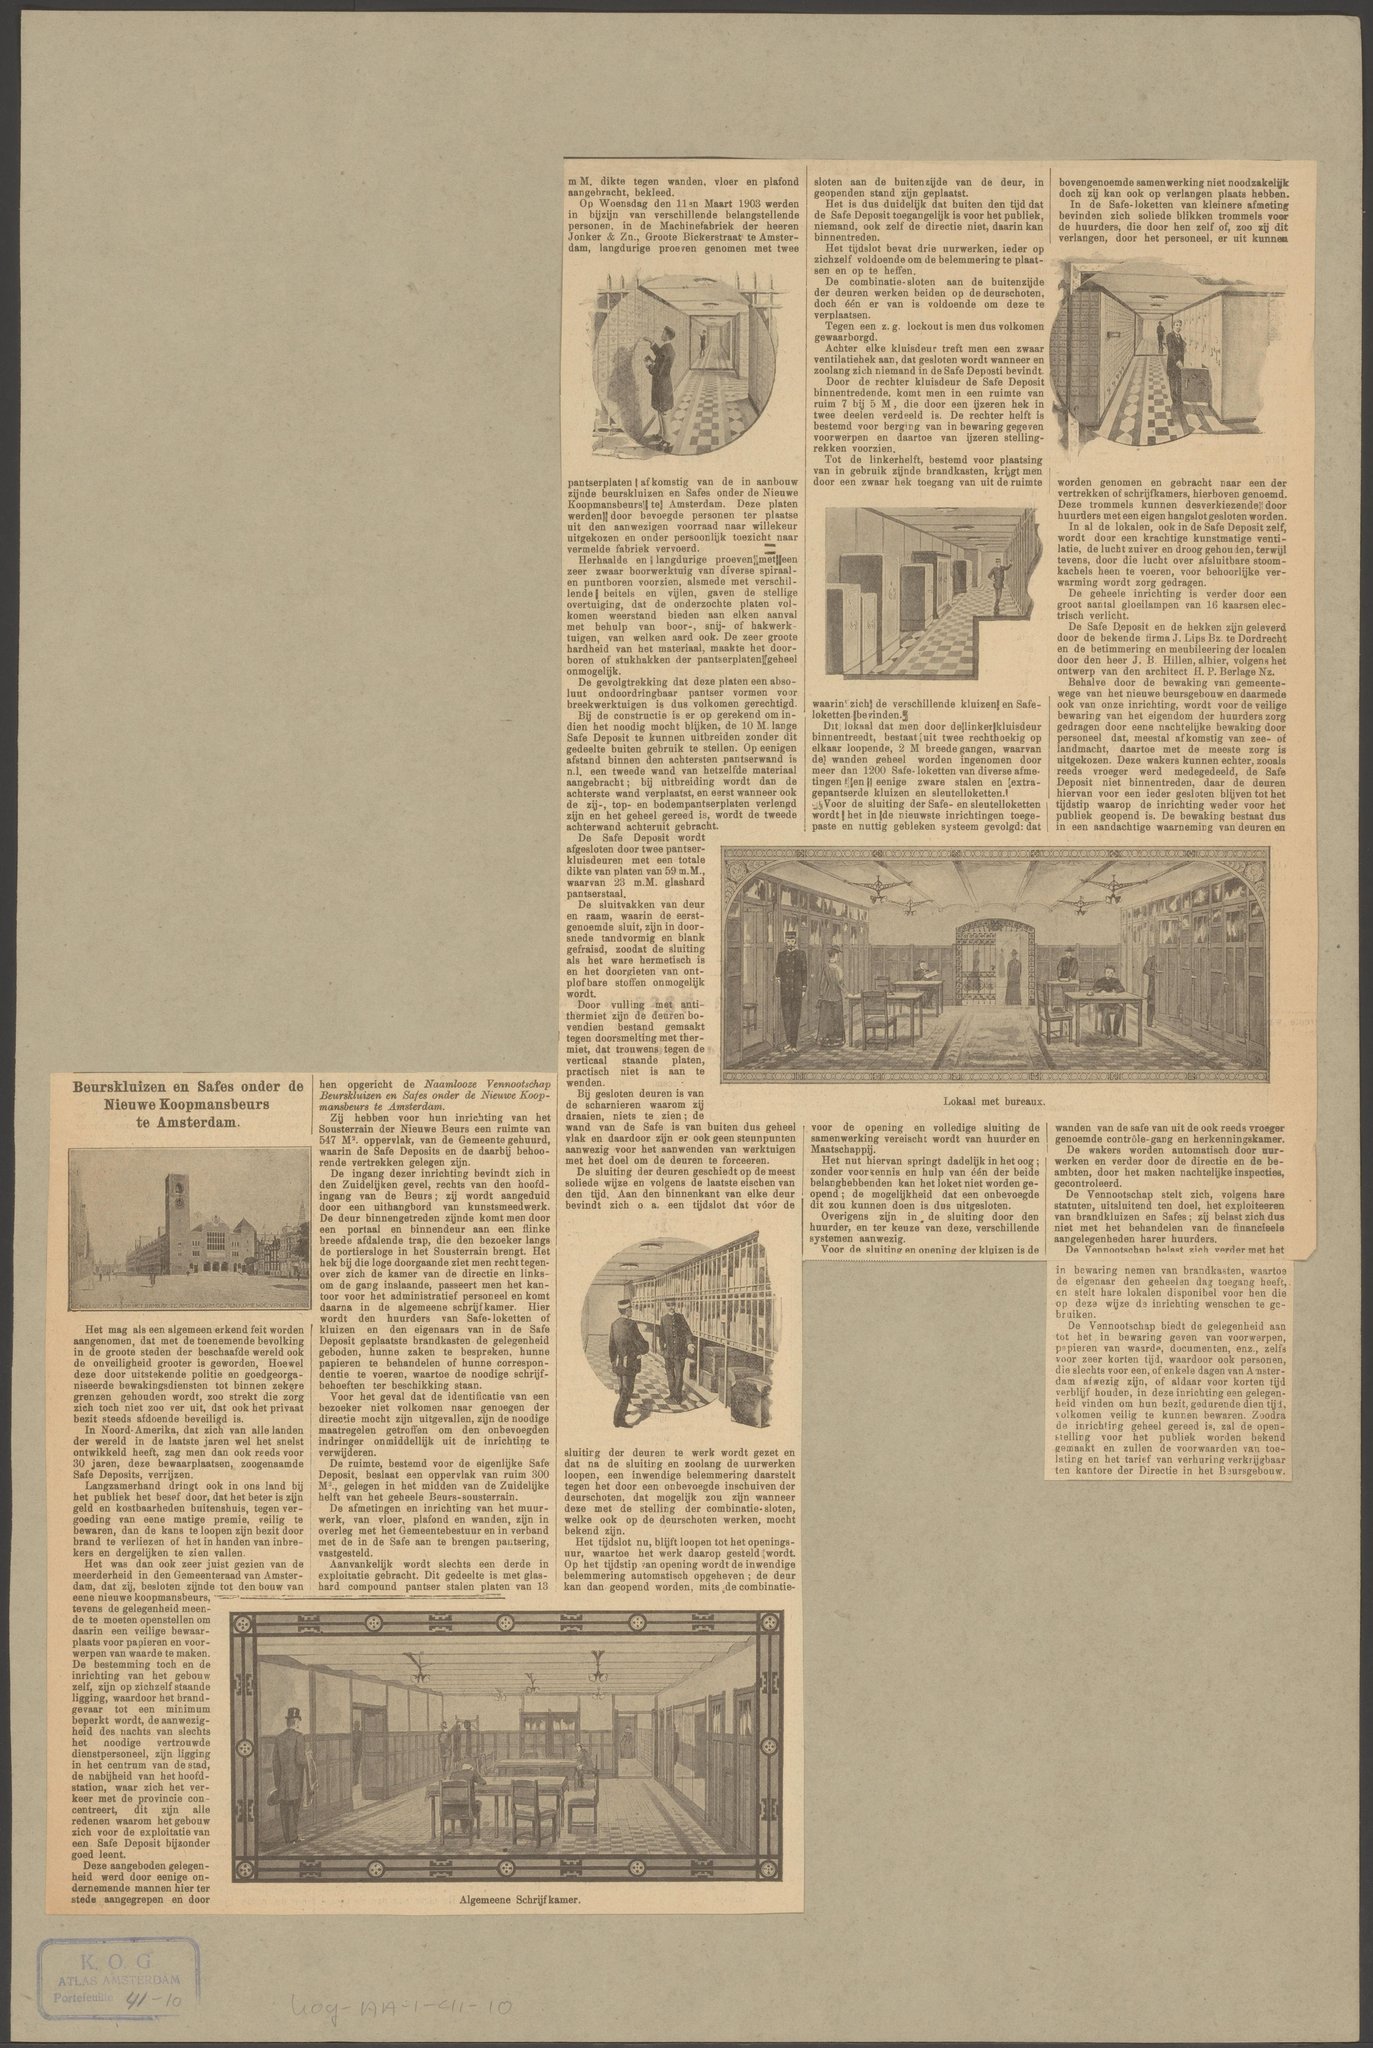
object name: photomechanical print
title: Beurskluizen en Safes onder de Nieuwe Koopmansbeurs te Amsterdam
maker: Anonymous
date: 1903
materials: paper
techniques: letterpress printing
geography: amsterdam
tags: stock exchange, stock-market, safe, strongbox, amsterdam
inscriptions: collector's mark: Lugt 1461b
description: Zeven afbeeldingen van de kluizen in de Beurs van Berlage in verschillende ruimtes. Onderwerpsrubriek binnen de Atlas Amsterdam: B. Beurs op het Damrak.